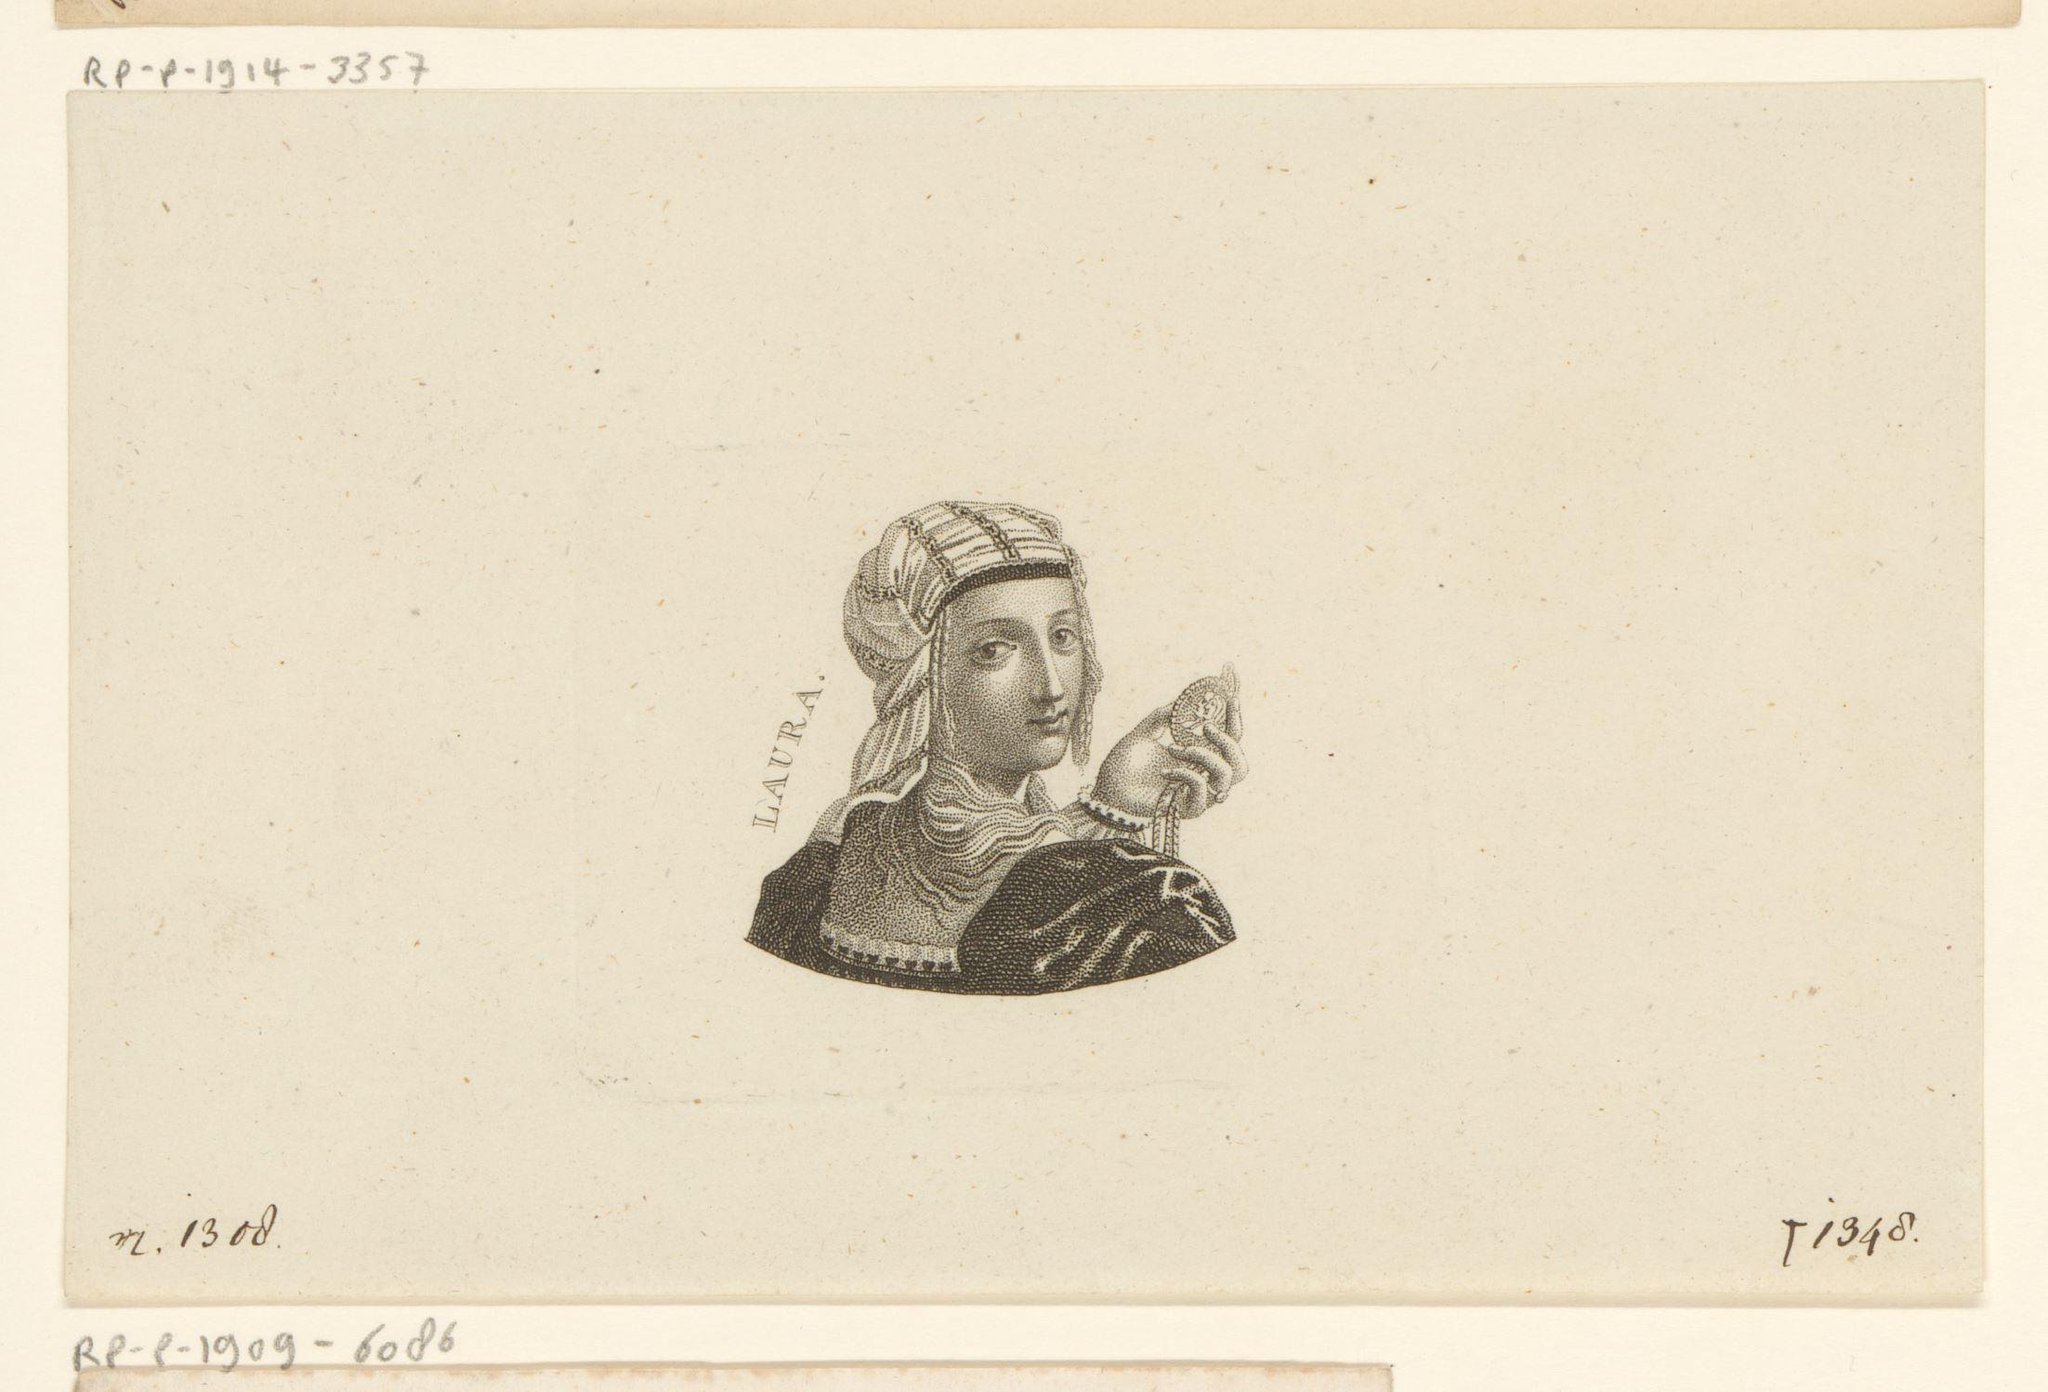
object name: print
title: Portret van Laura de Noves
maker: ernst ludwig riepenhausen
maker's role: print maker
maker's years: 1765-1840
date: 1775-1840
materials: paper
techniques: engraving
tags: historical persons - bb - woman, pendant, trinket, 'breloque'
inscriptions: date, collector's mark: Lugt 2228